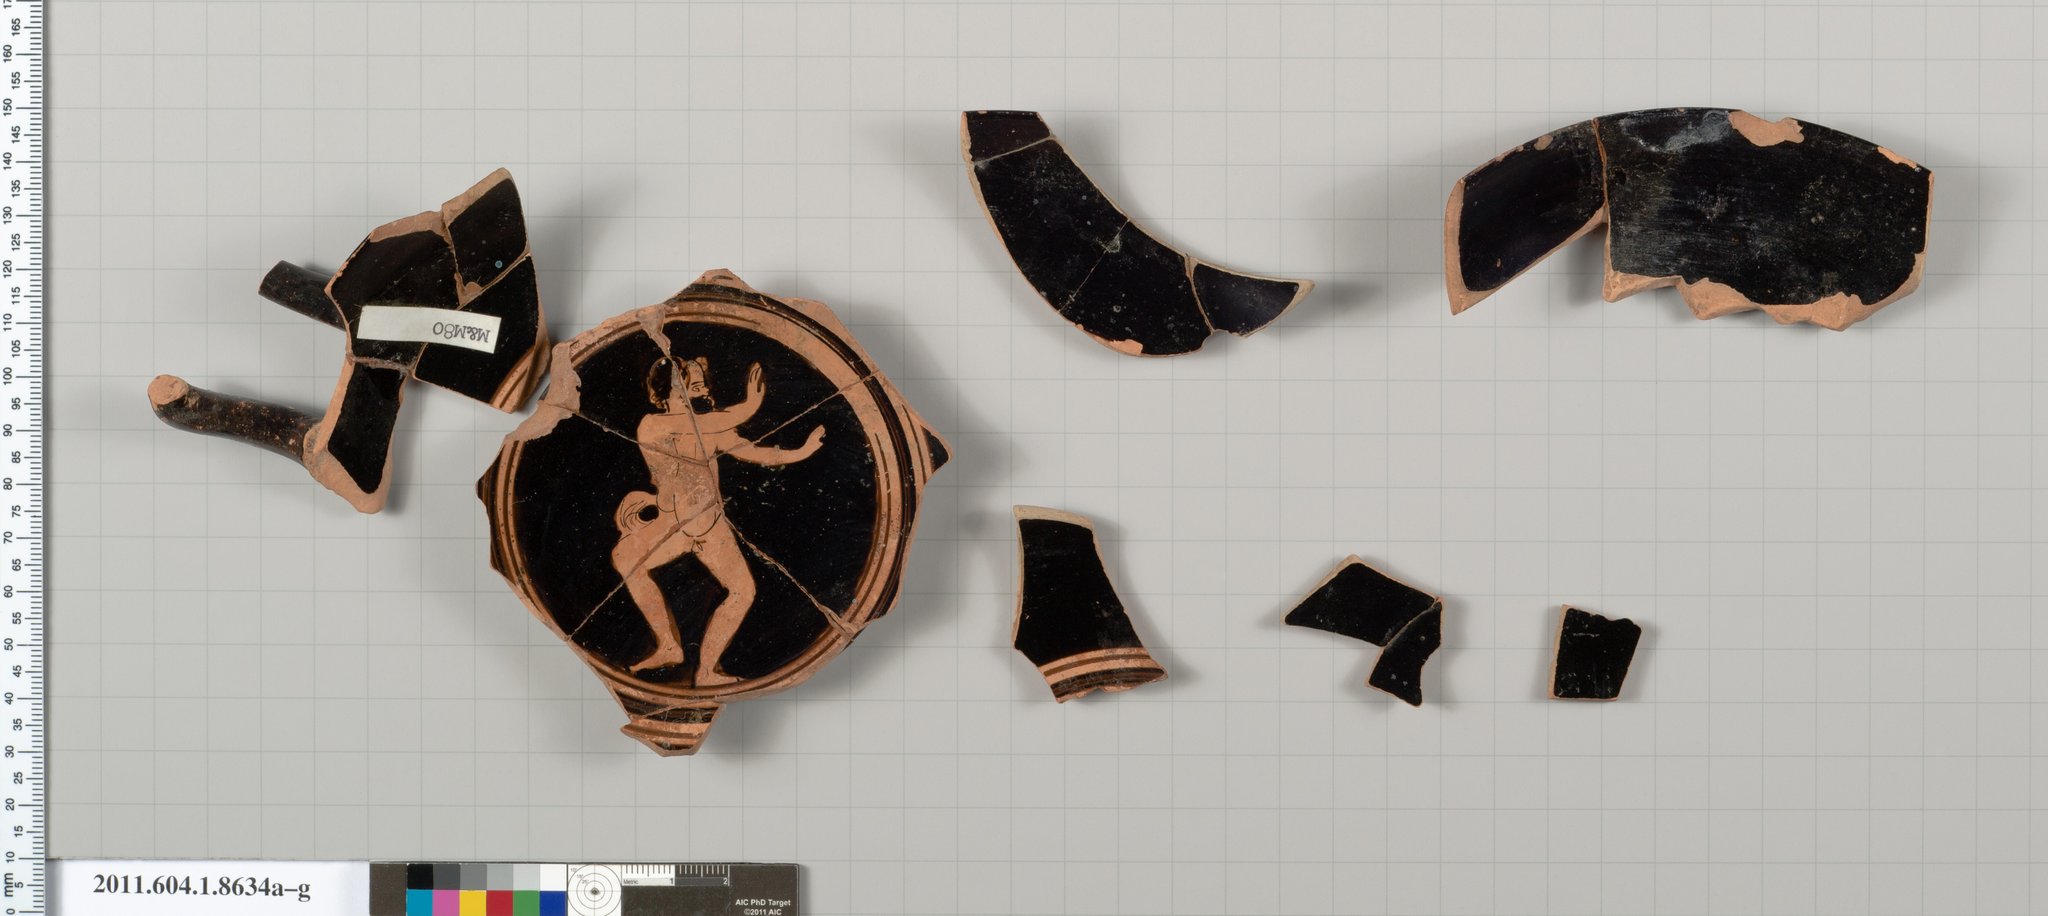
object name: kylix fragment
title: Terracotta fragments of a stemless kylix (drinking cup)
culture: greek, attic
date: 460-450 BCE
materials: terracotta